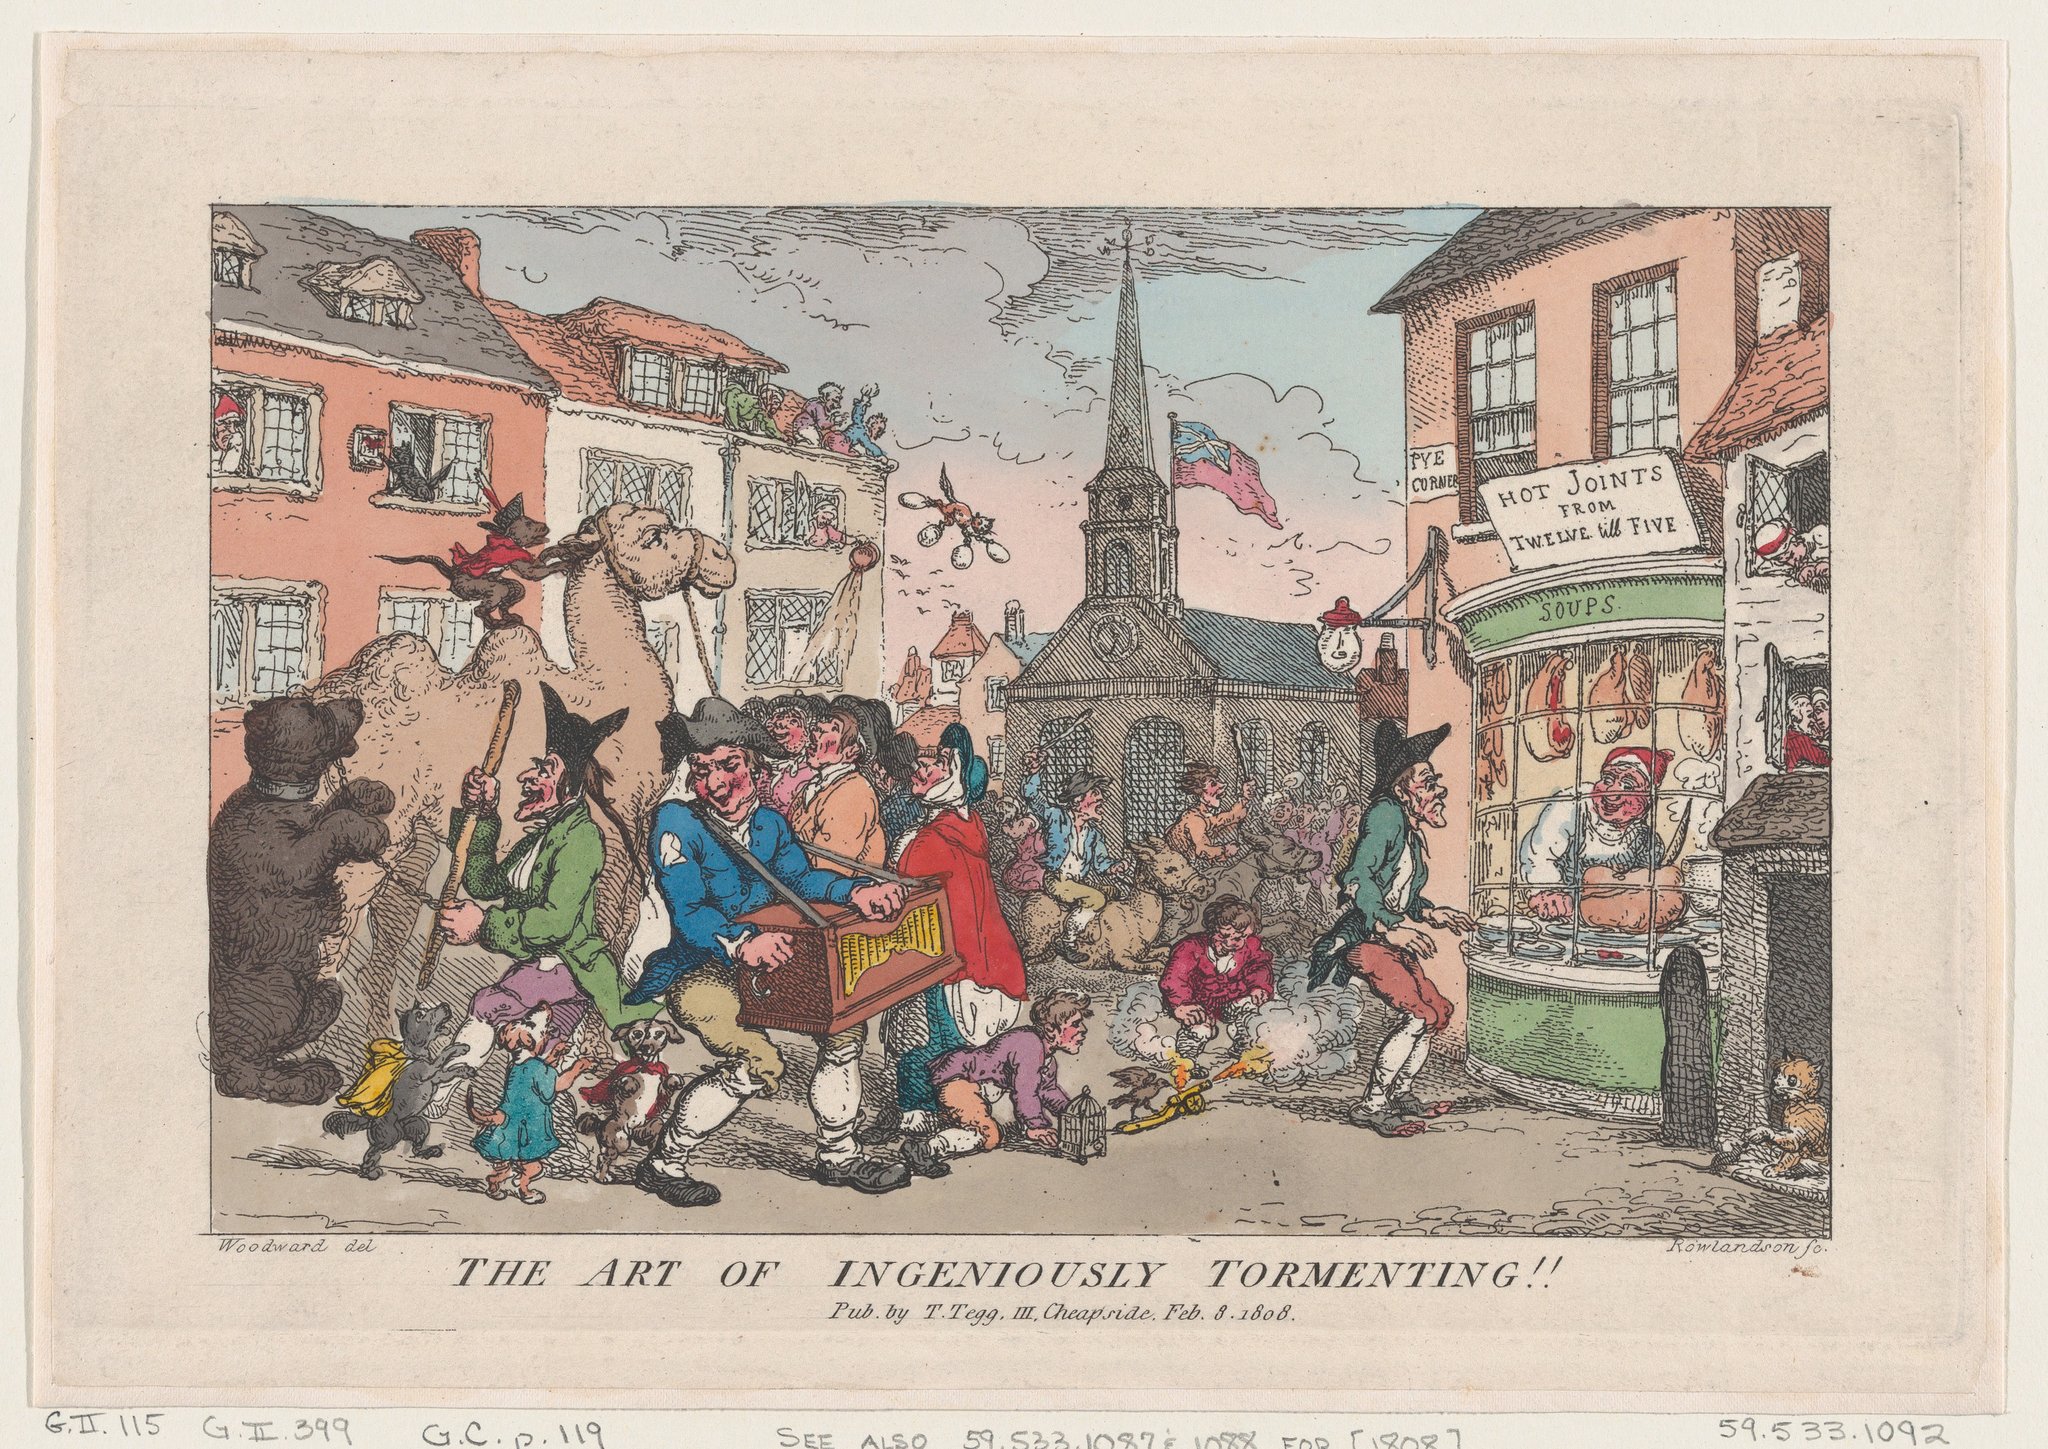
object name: print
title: The Art of Ingeniously Tormenting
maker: thomas rowlandson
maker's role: artist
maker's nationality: british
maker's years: 1757-1827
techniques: etching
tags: bears,satire,men,camels,dogs,monkeys